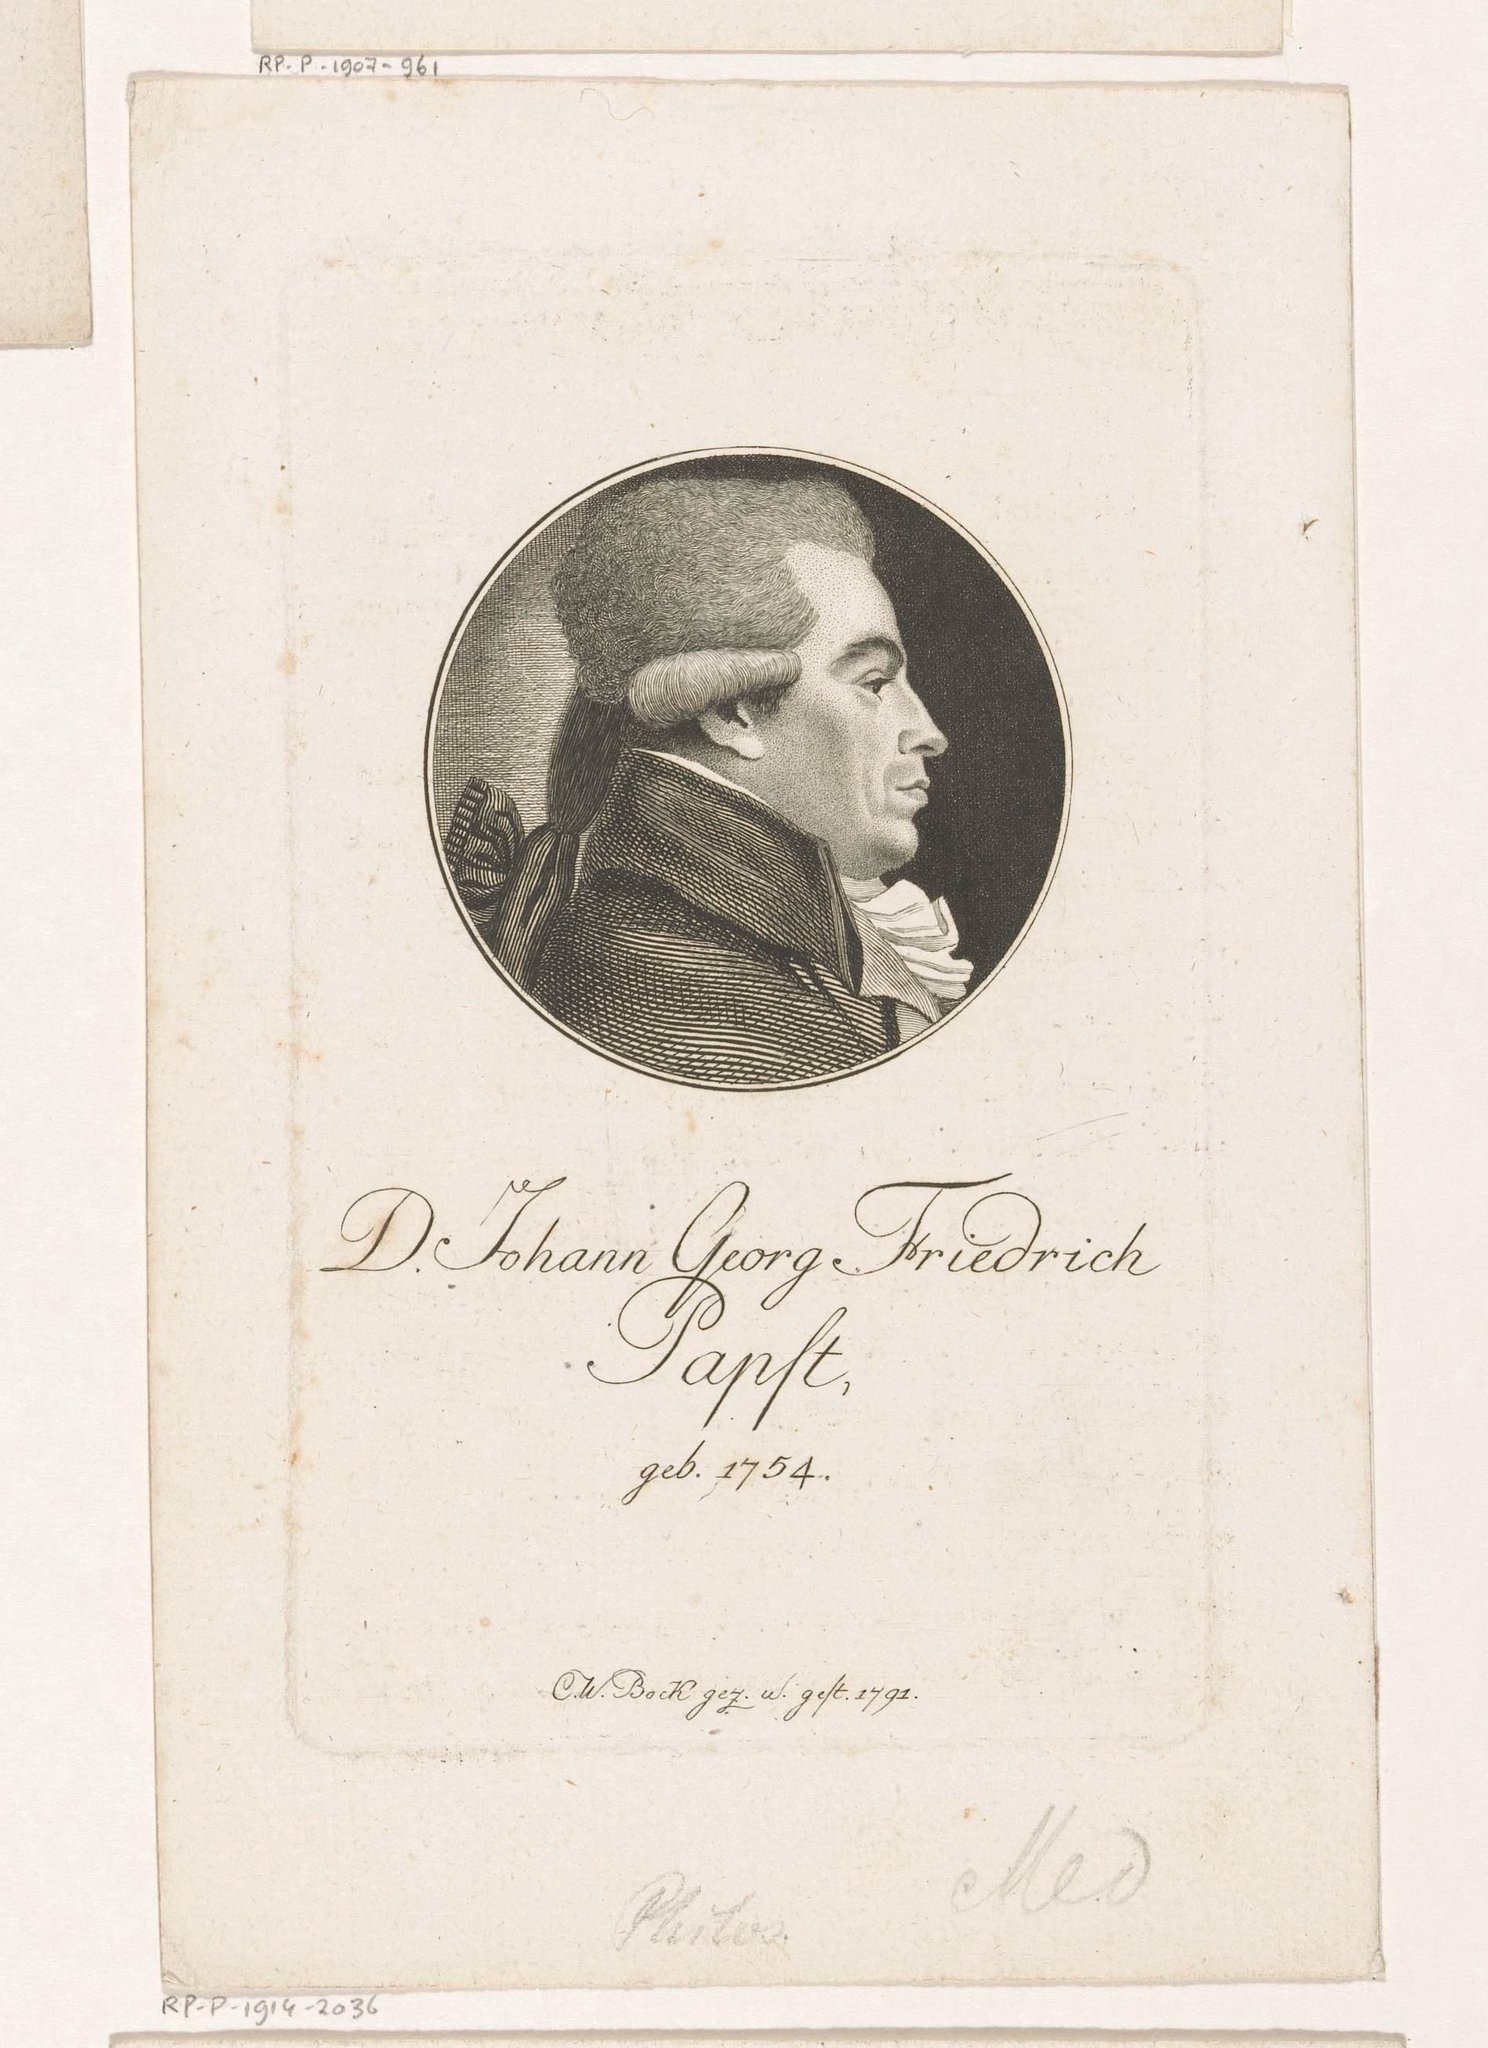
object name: print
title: Portret van Johann Georg Friedrich Pabst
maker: christoph wilhelm bock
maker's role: print maker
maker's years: 1755-1836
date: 1791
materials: paper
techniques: engraving, etching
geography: nuremberg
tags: historical persons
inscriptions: collector's mark: Lugt 2228